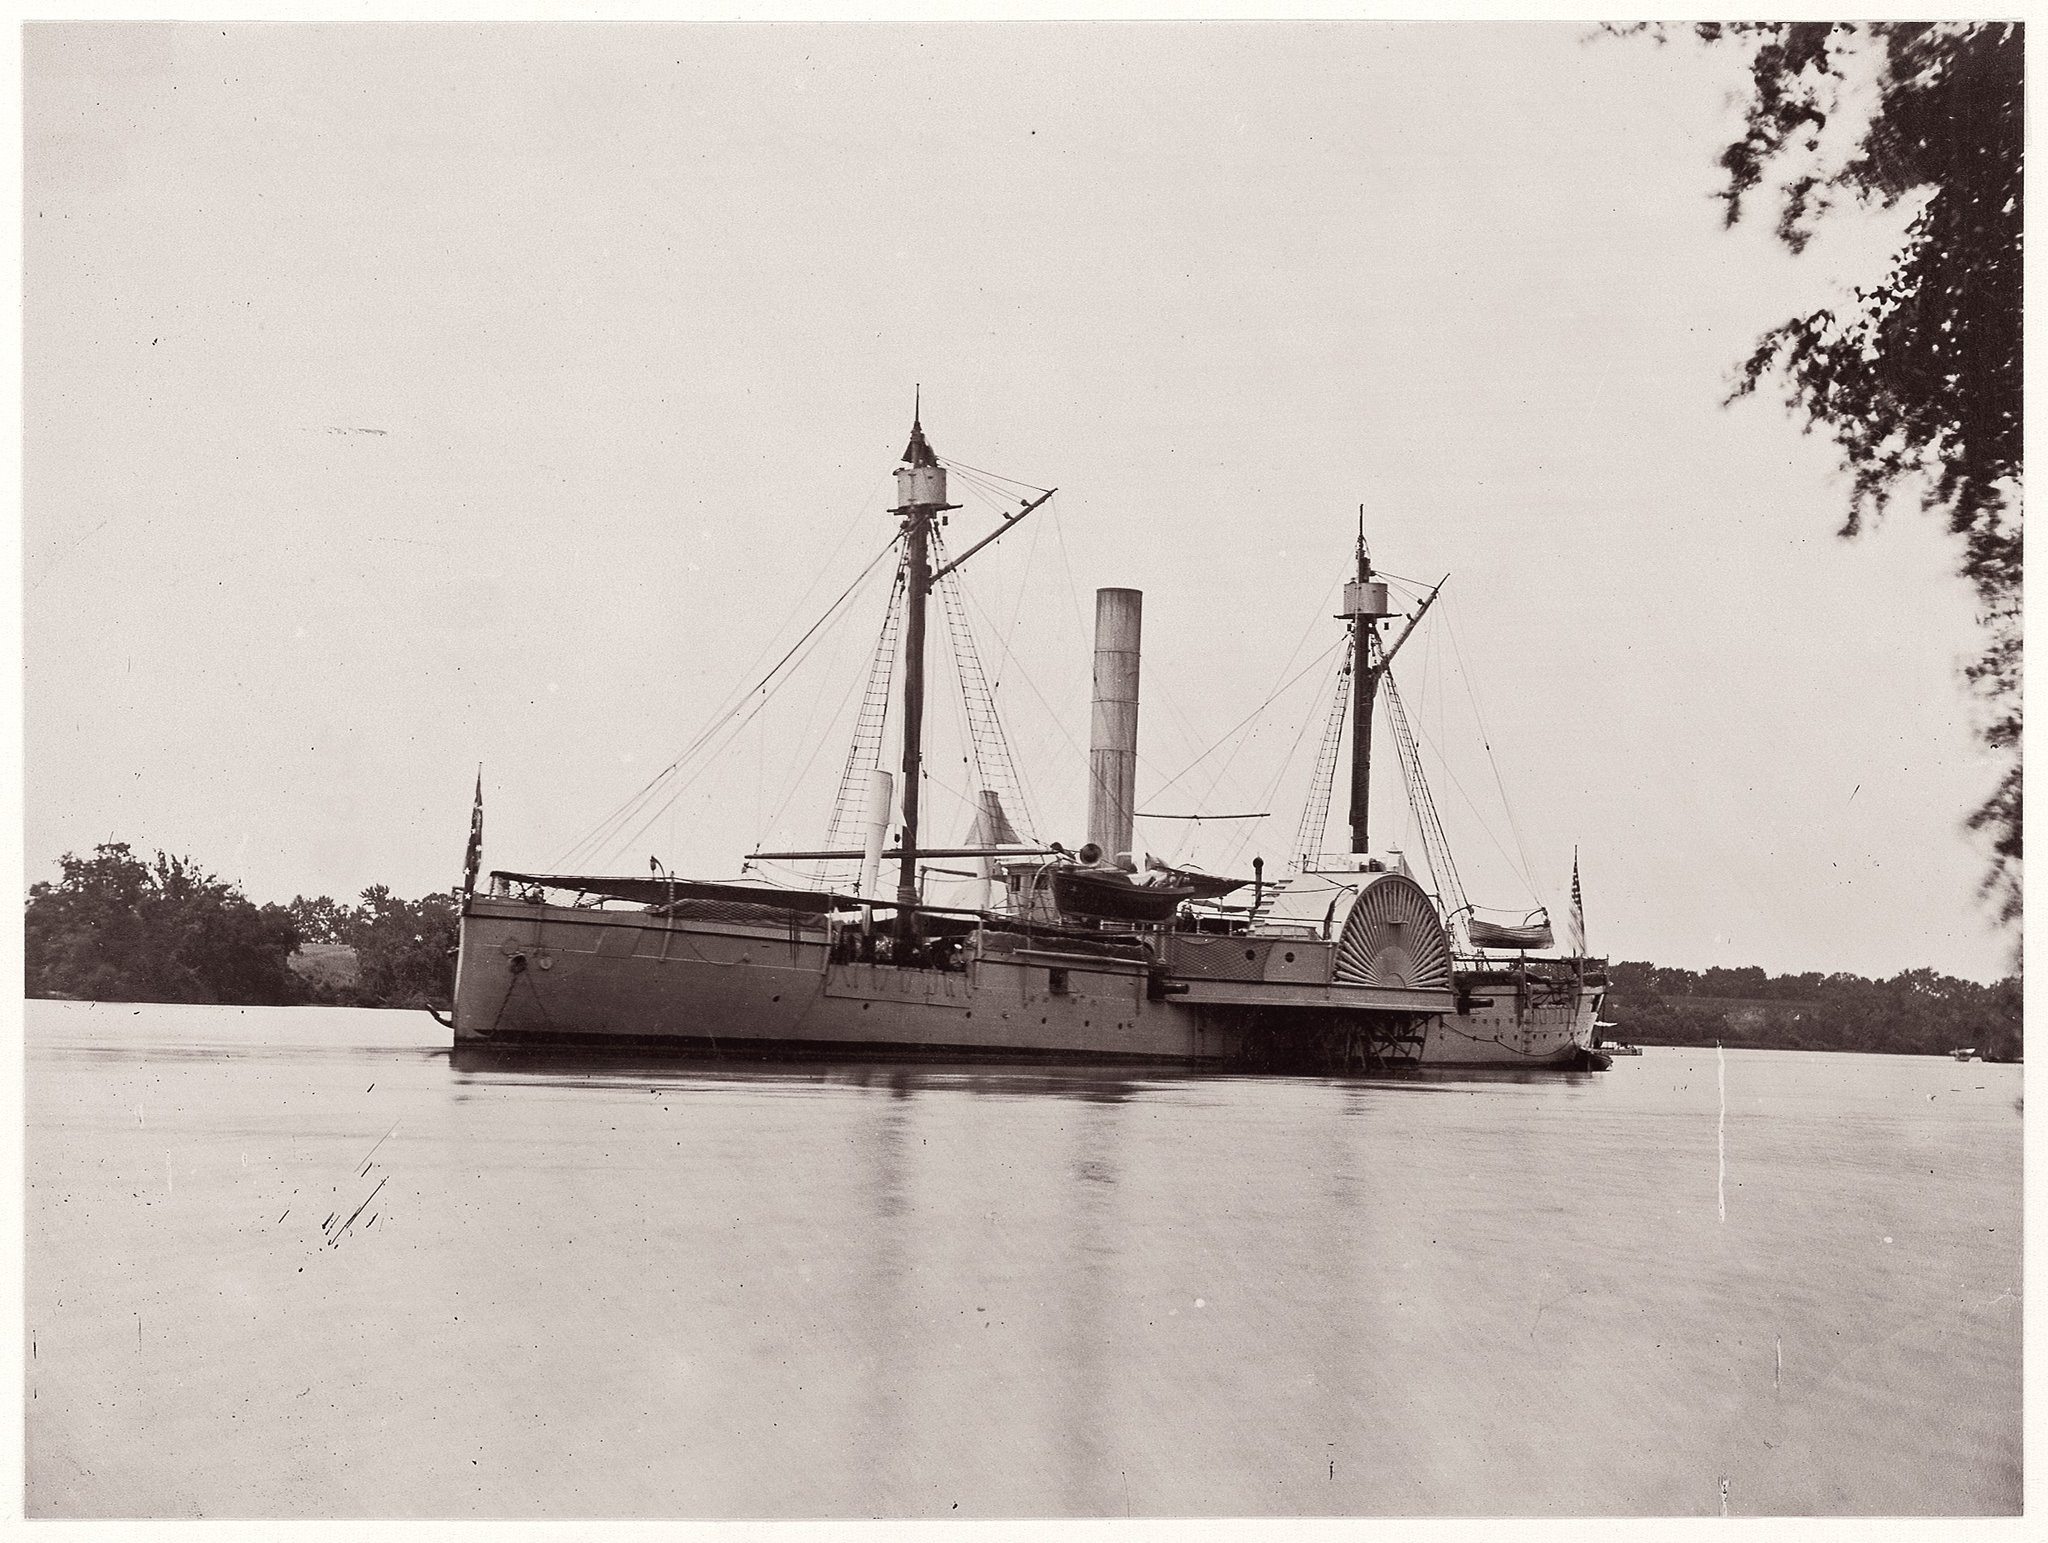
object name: photograph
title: U.S. Ship "Mendota", James River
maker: Anonymous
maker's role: artist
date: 1861-1865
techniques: albumen silver print, glass negative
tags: american civil war,rivers,ships